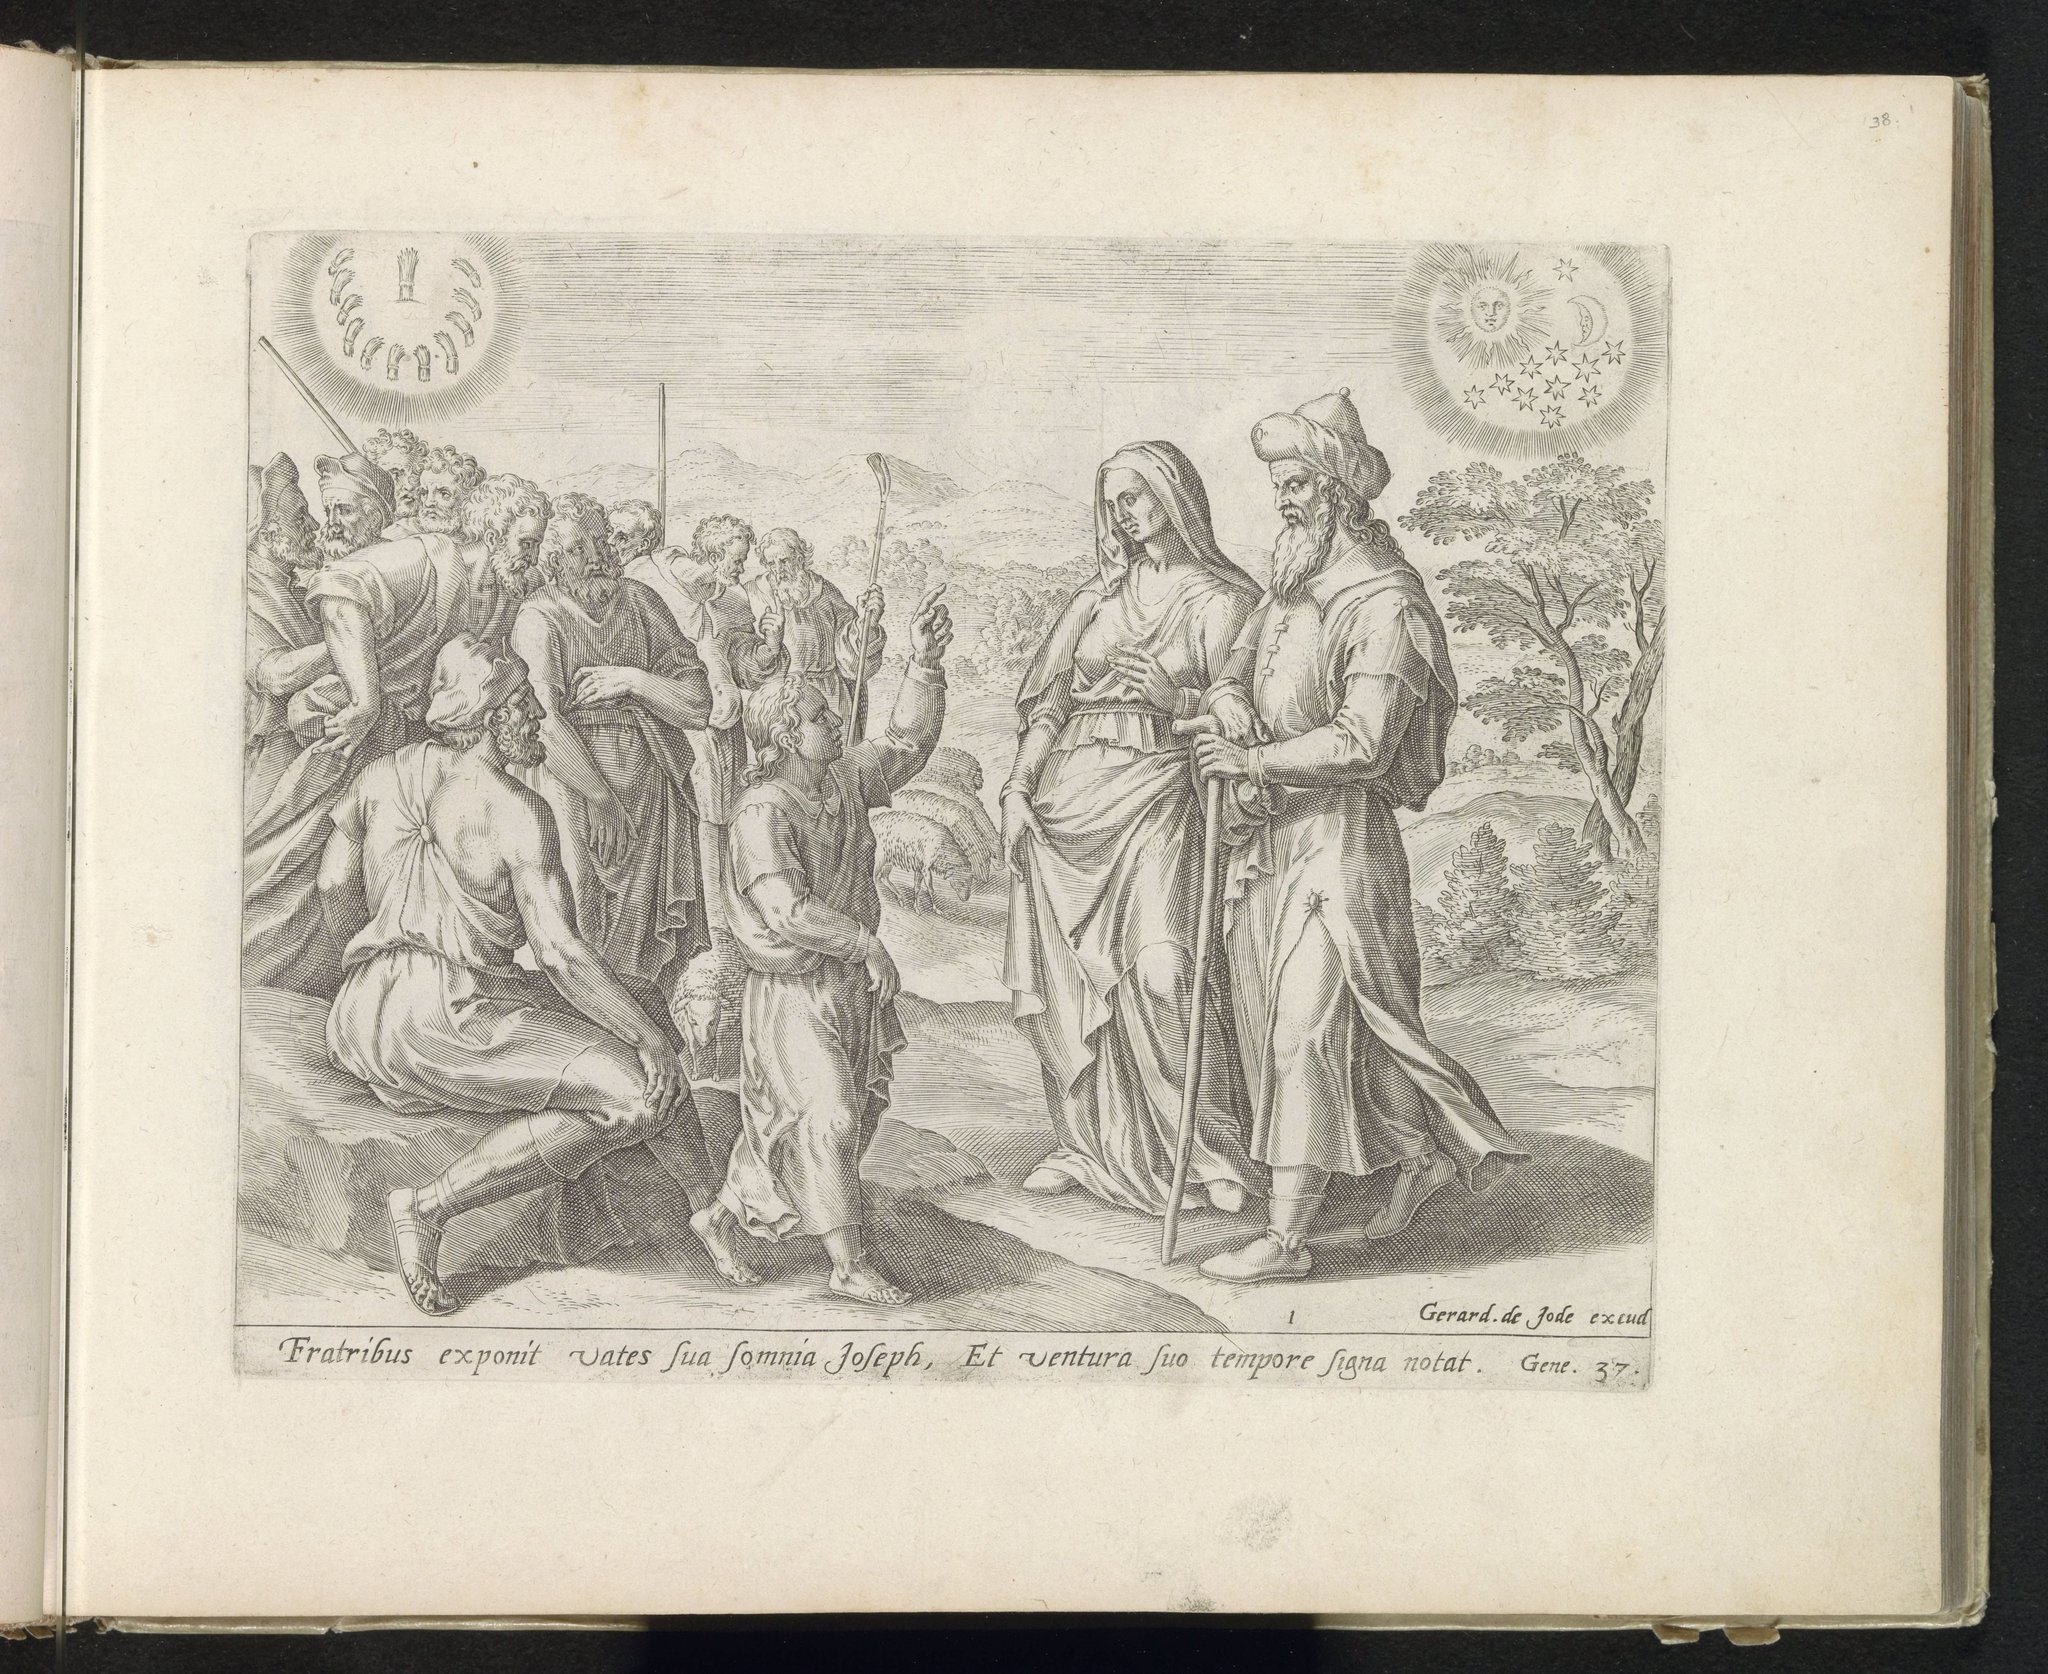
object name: print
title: Thesaurus sacrarum historiaru[m] veteris testame[n]ti, elega[n]tissimis imaginibus expressu[m] excelle[n]tissimoru[m] in hac arte viroru[m] opera: nu[n]c primu[m] in luce[m] editus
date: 1585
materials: paper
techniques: engraving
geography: antwerp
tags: joseph relating his dreams (the two dreams combined)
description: Jozef legt zijn dromen uit aan zijn ouders en zijn broers. Linksboven de droom van de korenschoven, waarbij de korenschoven van zijn broers voor Jozefs korenschoof buigen. Rechtsboven de droom, waarin de zon, man en elf sterren zich voor Jozef buigen. Onder de voorstelling een verwijzing in het Latijn naar de Bijbeltekst in Gen. 37. Deze prent maakt deel uit van een album.